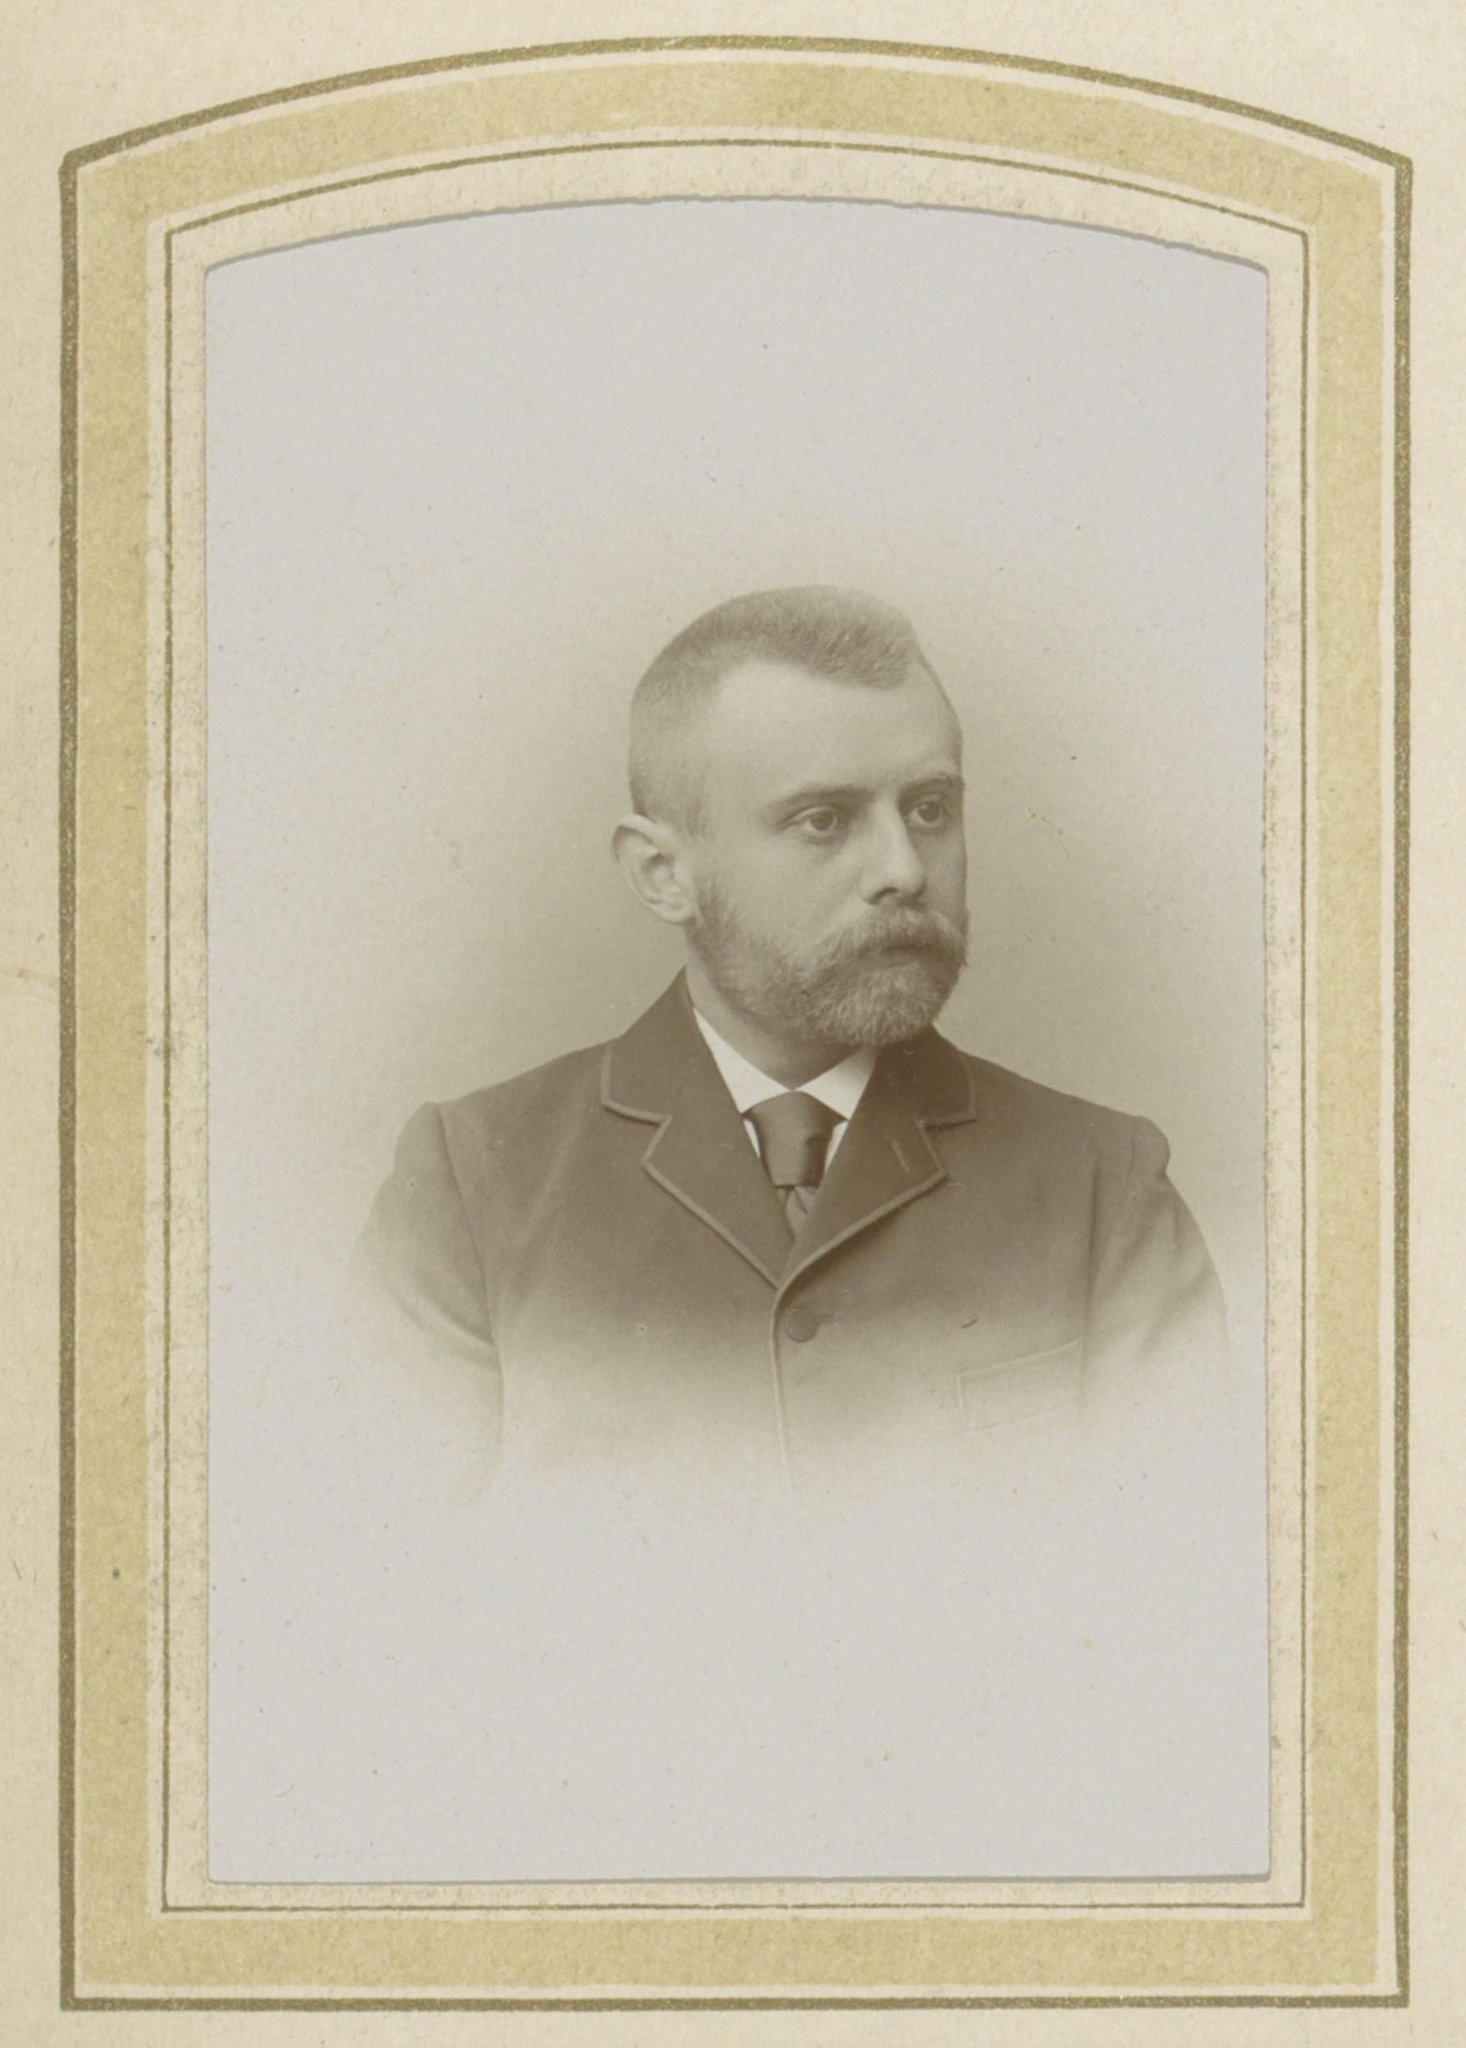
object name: photograph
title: Portret van een man met een baard en een das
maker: johan christiaan reesinck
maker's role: fotograaf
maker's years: 1838-1922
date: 1866-1900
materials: cardboard, paper, photographic support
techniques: daylight paper print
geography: netherlands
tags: historical persons, neck-gear ~ clothing, clothing for the upper part of the body, hairdress, beard, netherlands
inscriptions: address: ‘Zutphen Deventer’, address: ‘Zutphen Berkelkade B.300 Deventer Nieuwstraat 22’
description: Onderdeel van Fotoalbum van een Nederlandse familie met 168 cartes-de-visite en kabinetfoto's.